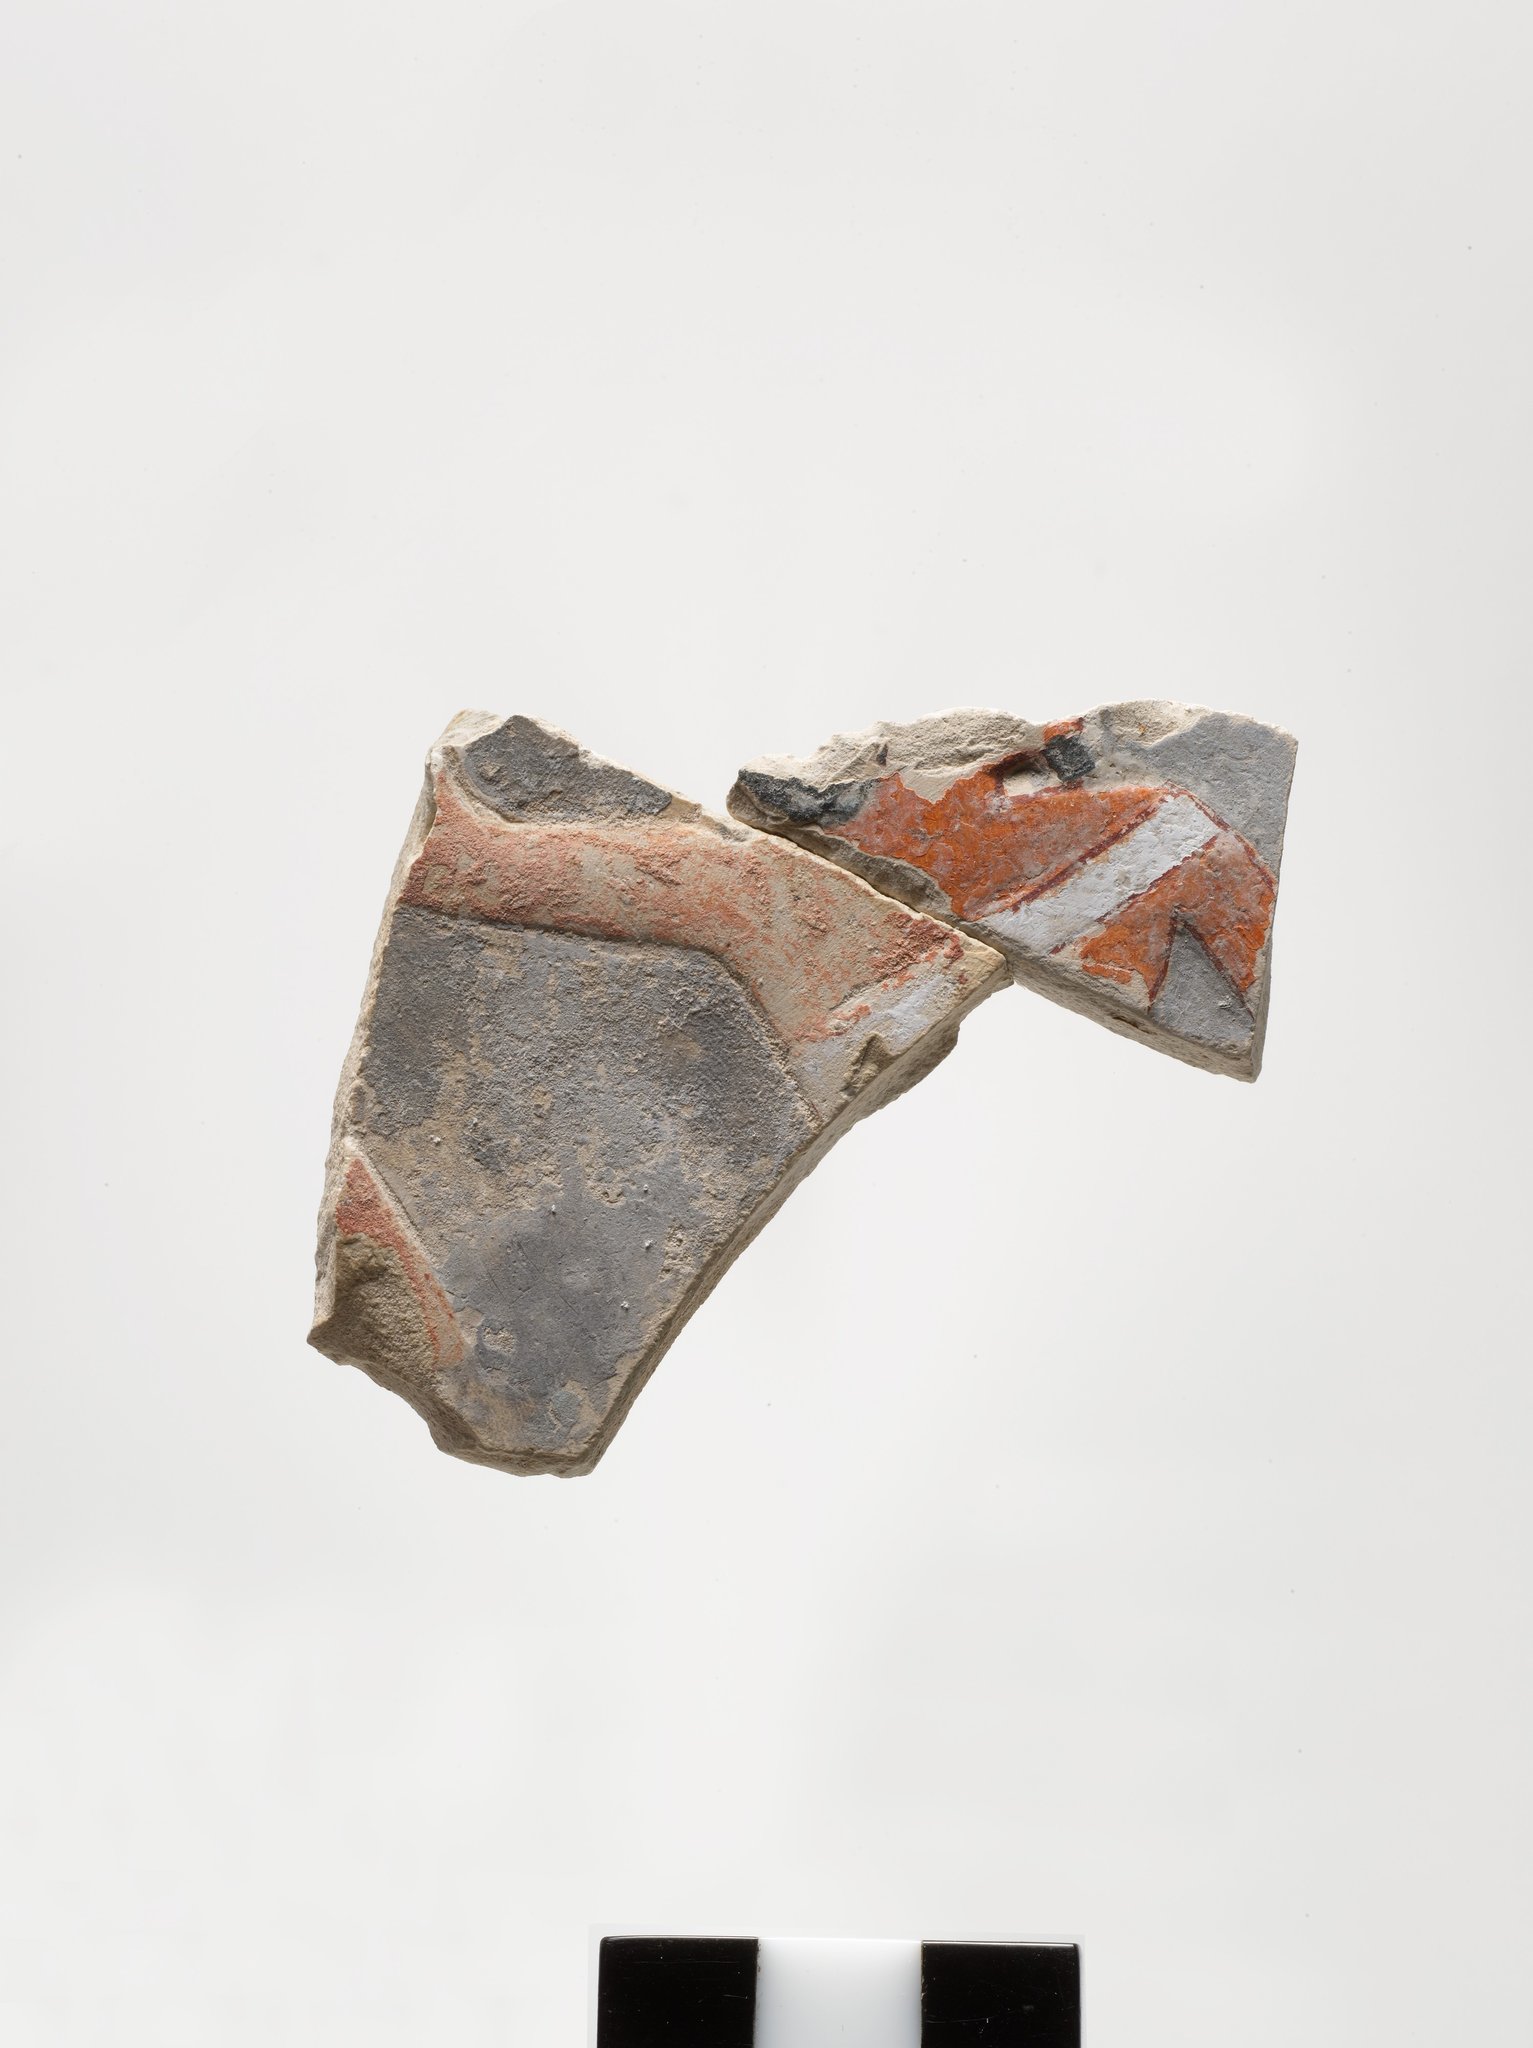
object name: relief fragment, tomb of meketre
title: Relief fragment from the tomb of Meketre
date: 1981-1975 BCE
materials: limestone, paint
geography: egypt